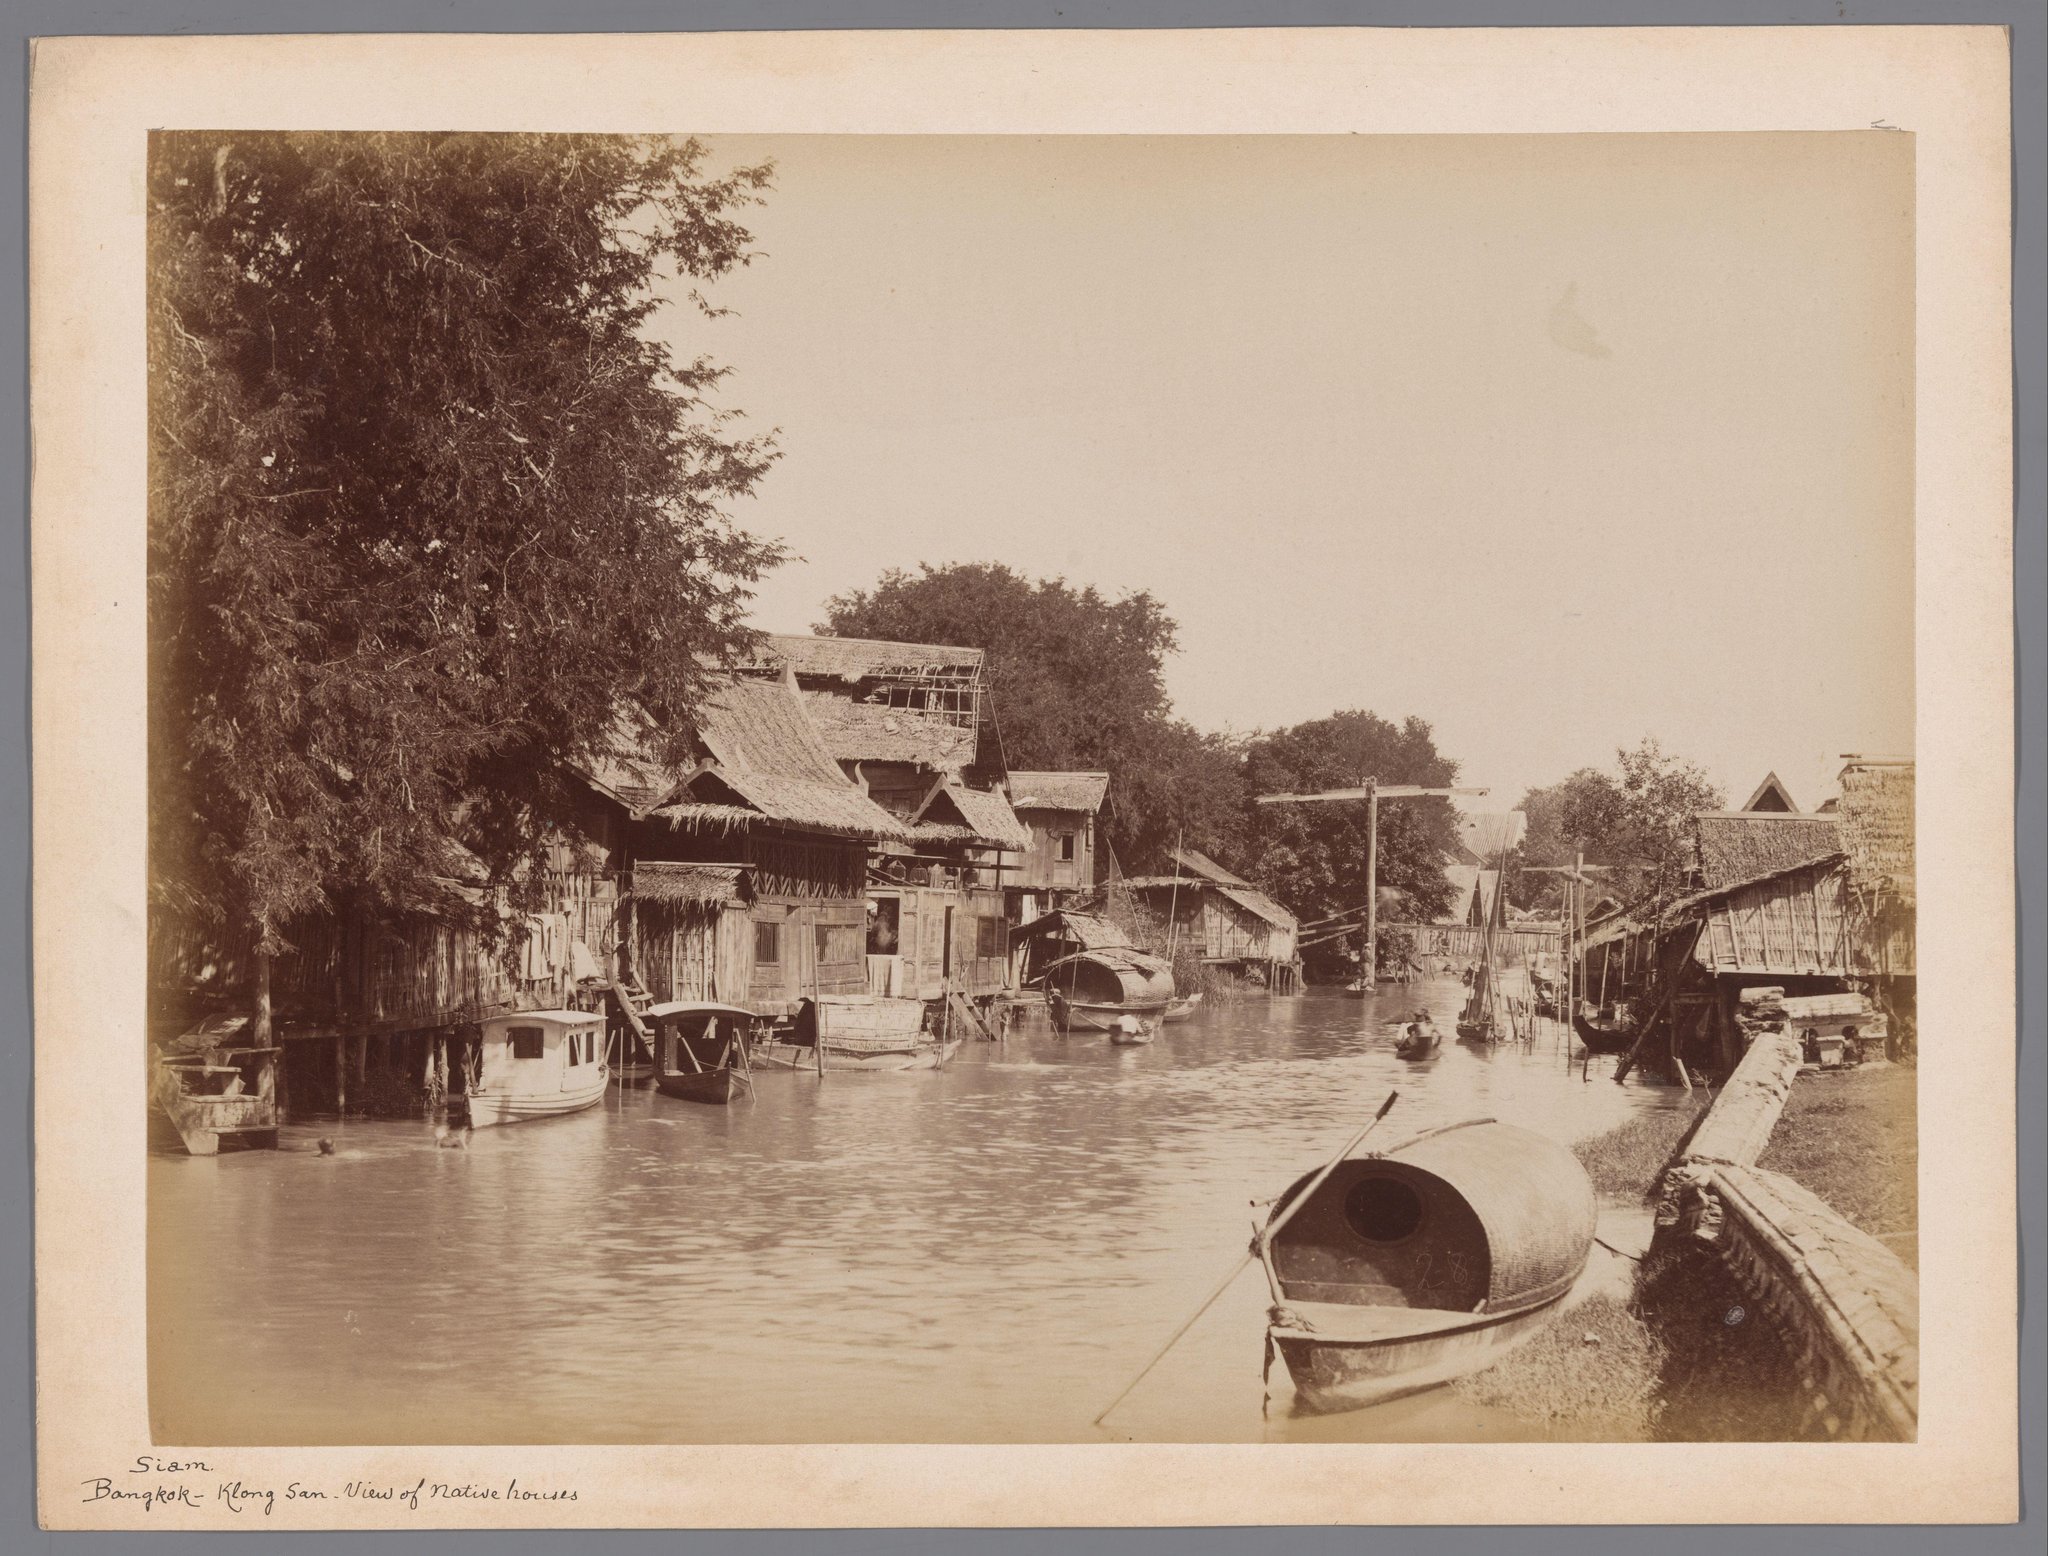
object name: photograph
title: Gezicht op woningen langs een khlong in Bangkok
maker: Anonymous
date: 1860-1900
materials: cardboard, paper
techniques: albumen print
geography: bangkok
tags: canals, waters (in city)